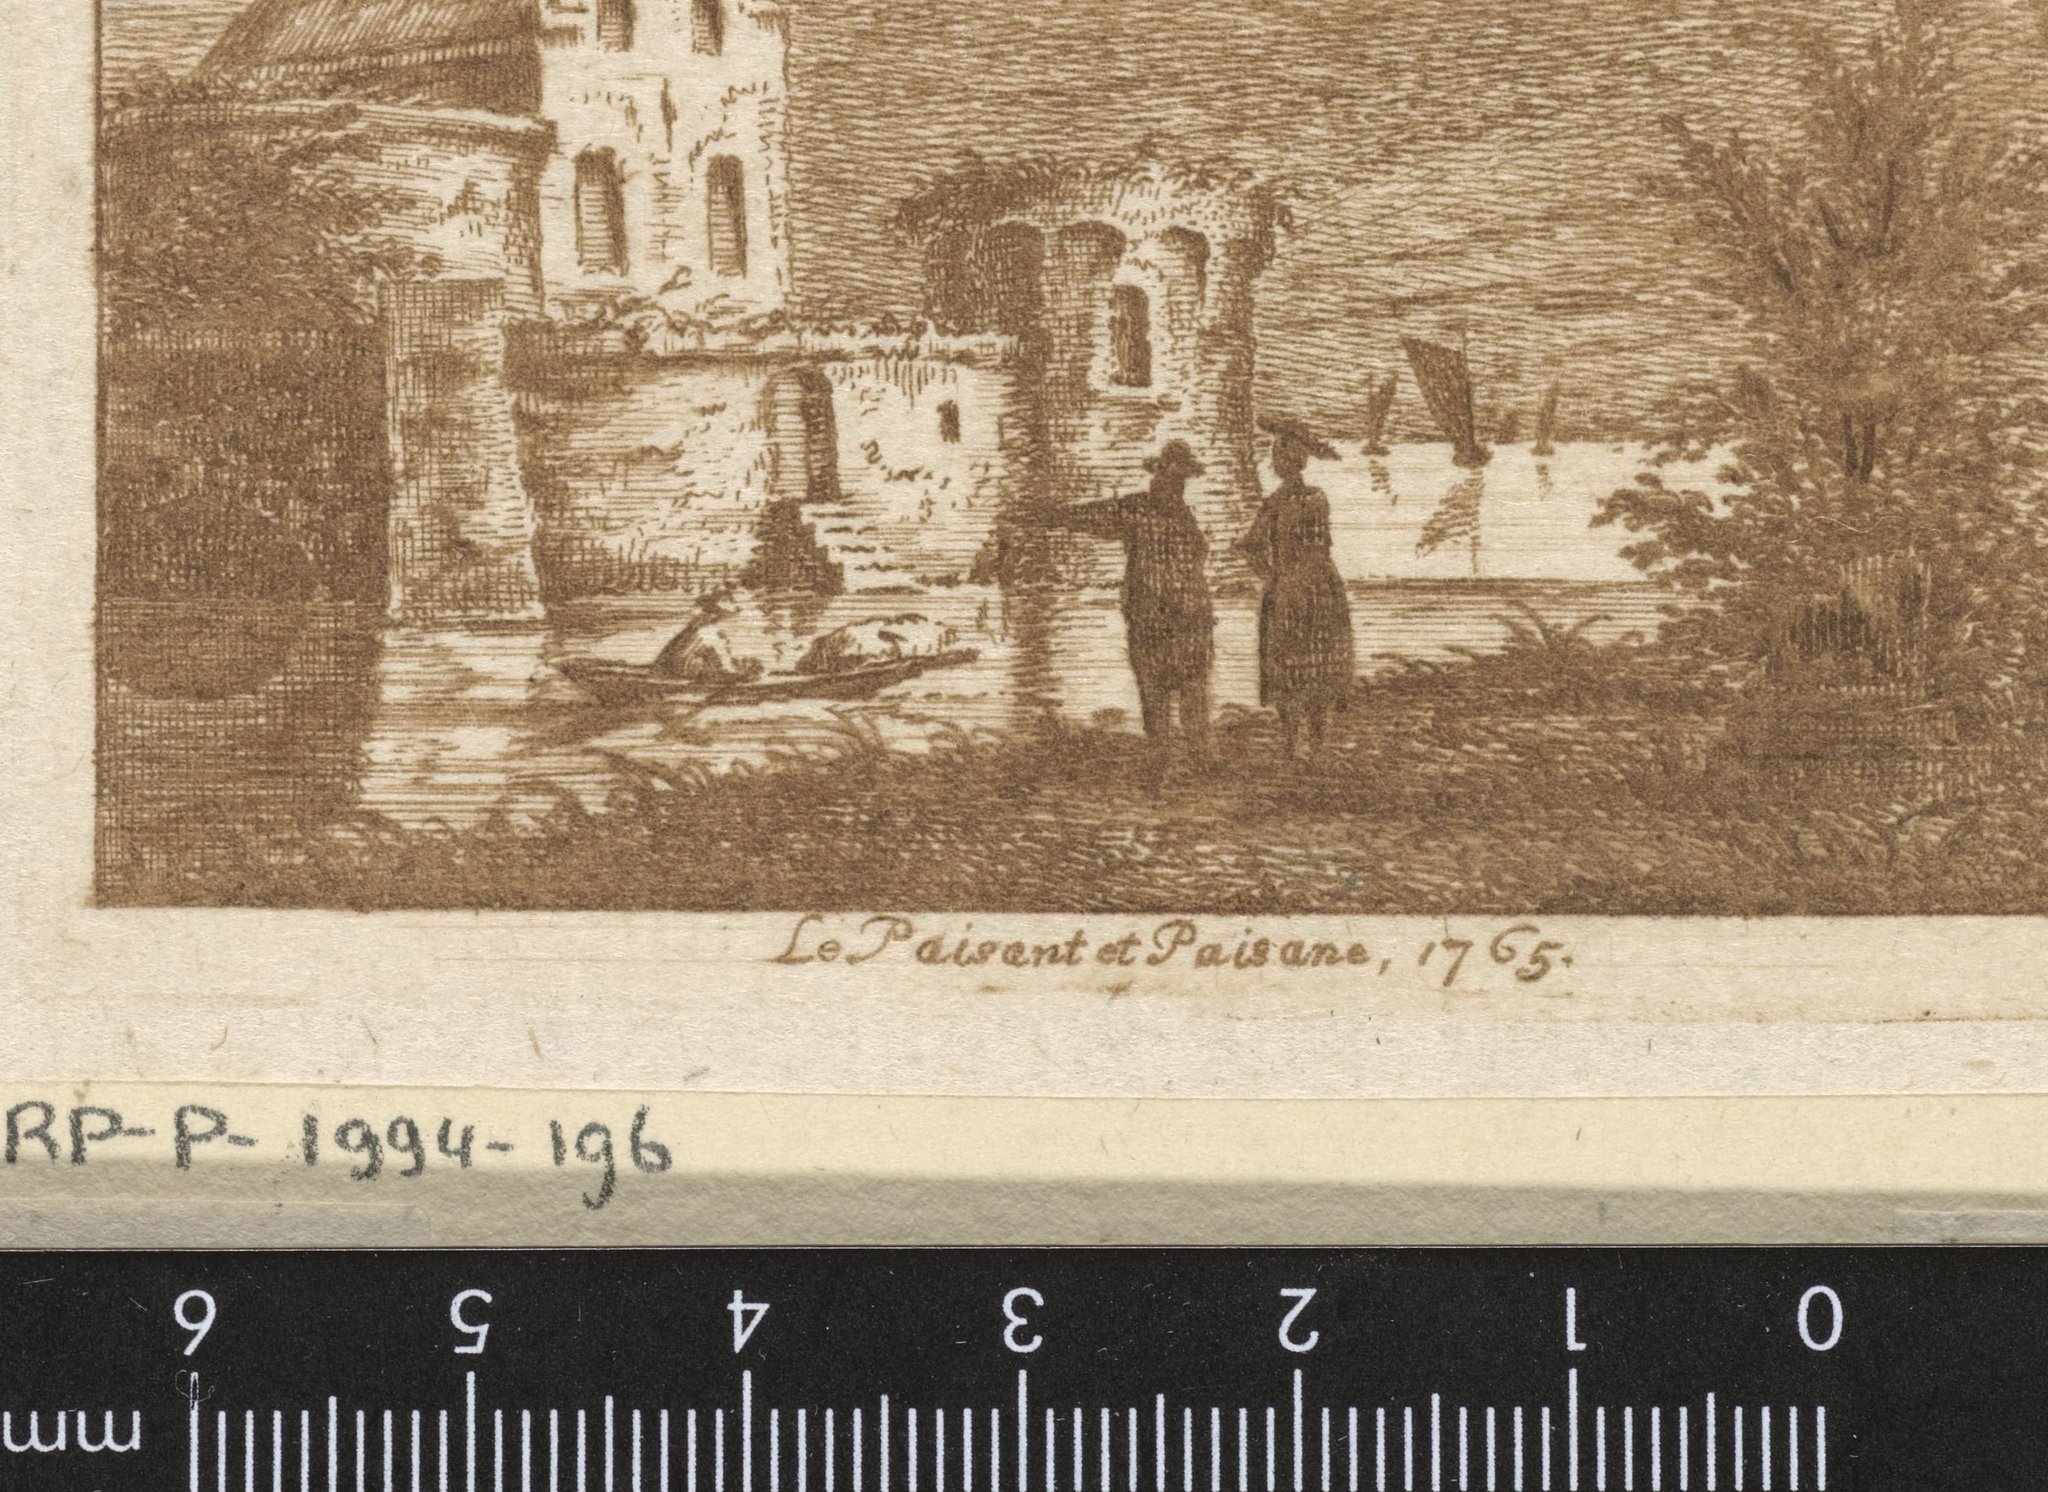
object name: print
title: Landschapjes, Rúwientjes enz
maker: caspar jacobsz. philips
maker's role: draughtsman, print maker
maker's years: 1732-1789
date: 1765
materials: paper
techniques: etching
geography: amsterdam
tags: river bank, civic architecture; edifices; dwellings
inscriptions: date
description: Een man en een vrouw staan op de oever van een rivier en kijken uit op een ommuurd slot. Op de rivier een roeiboot.